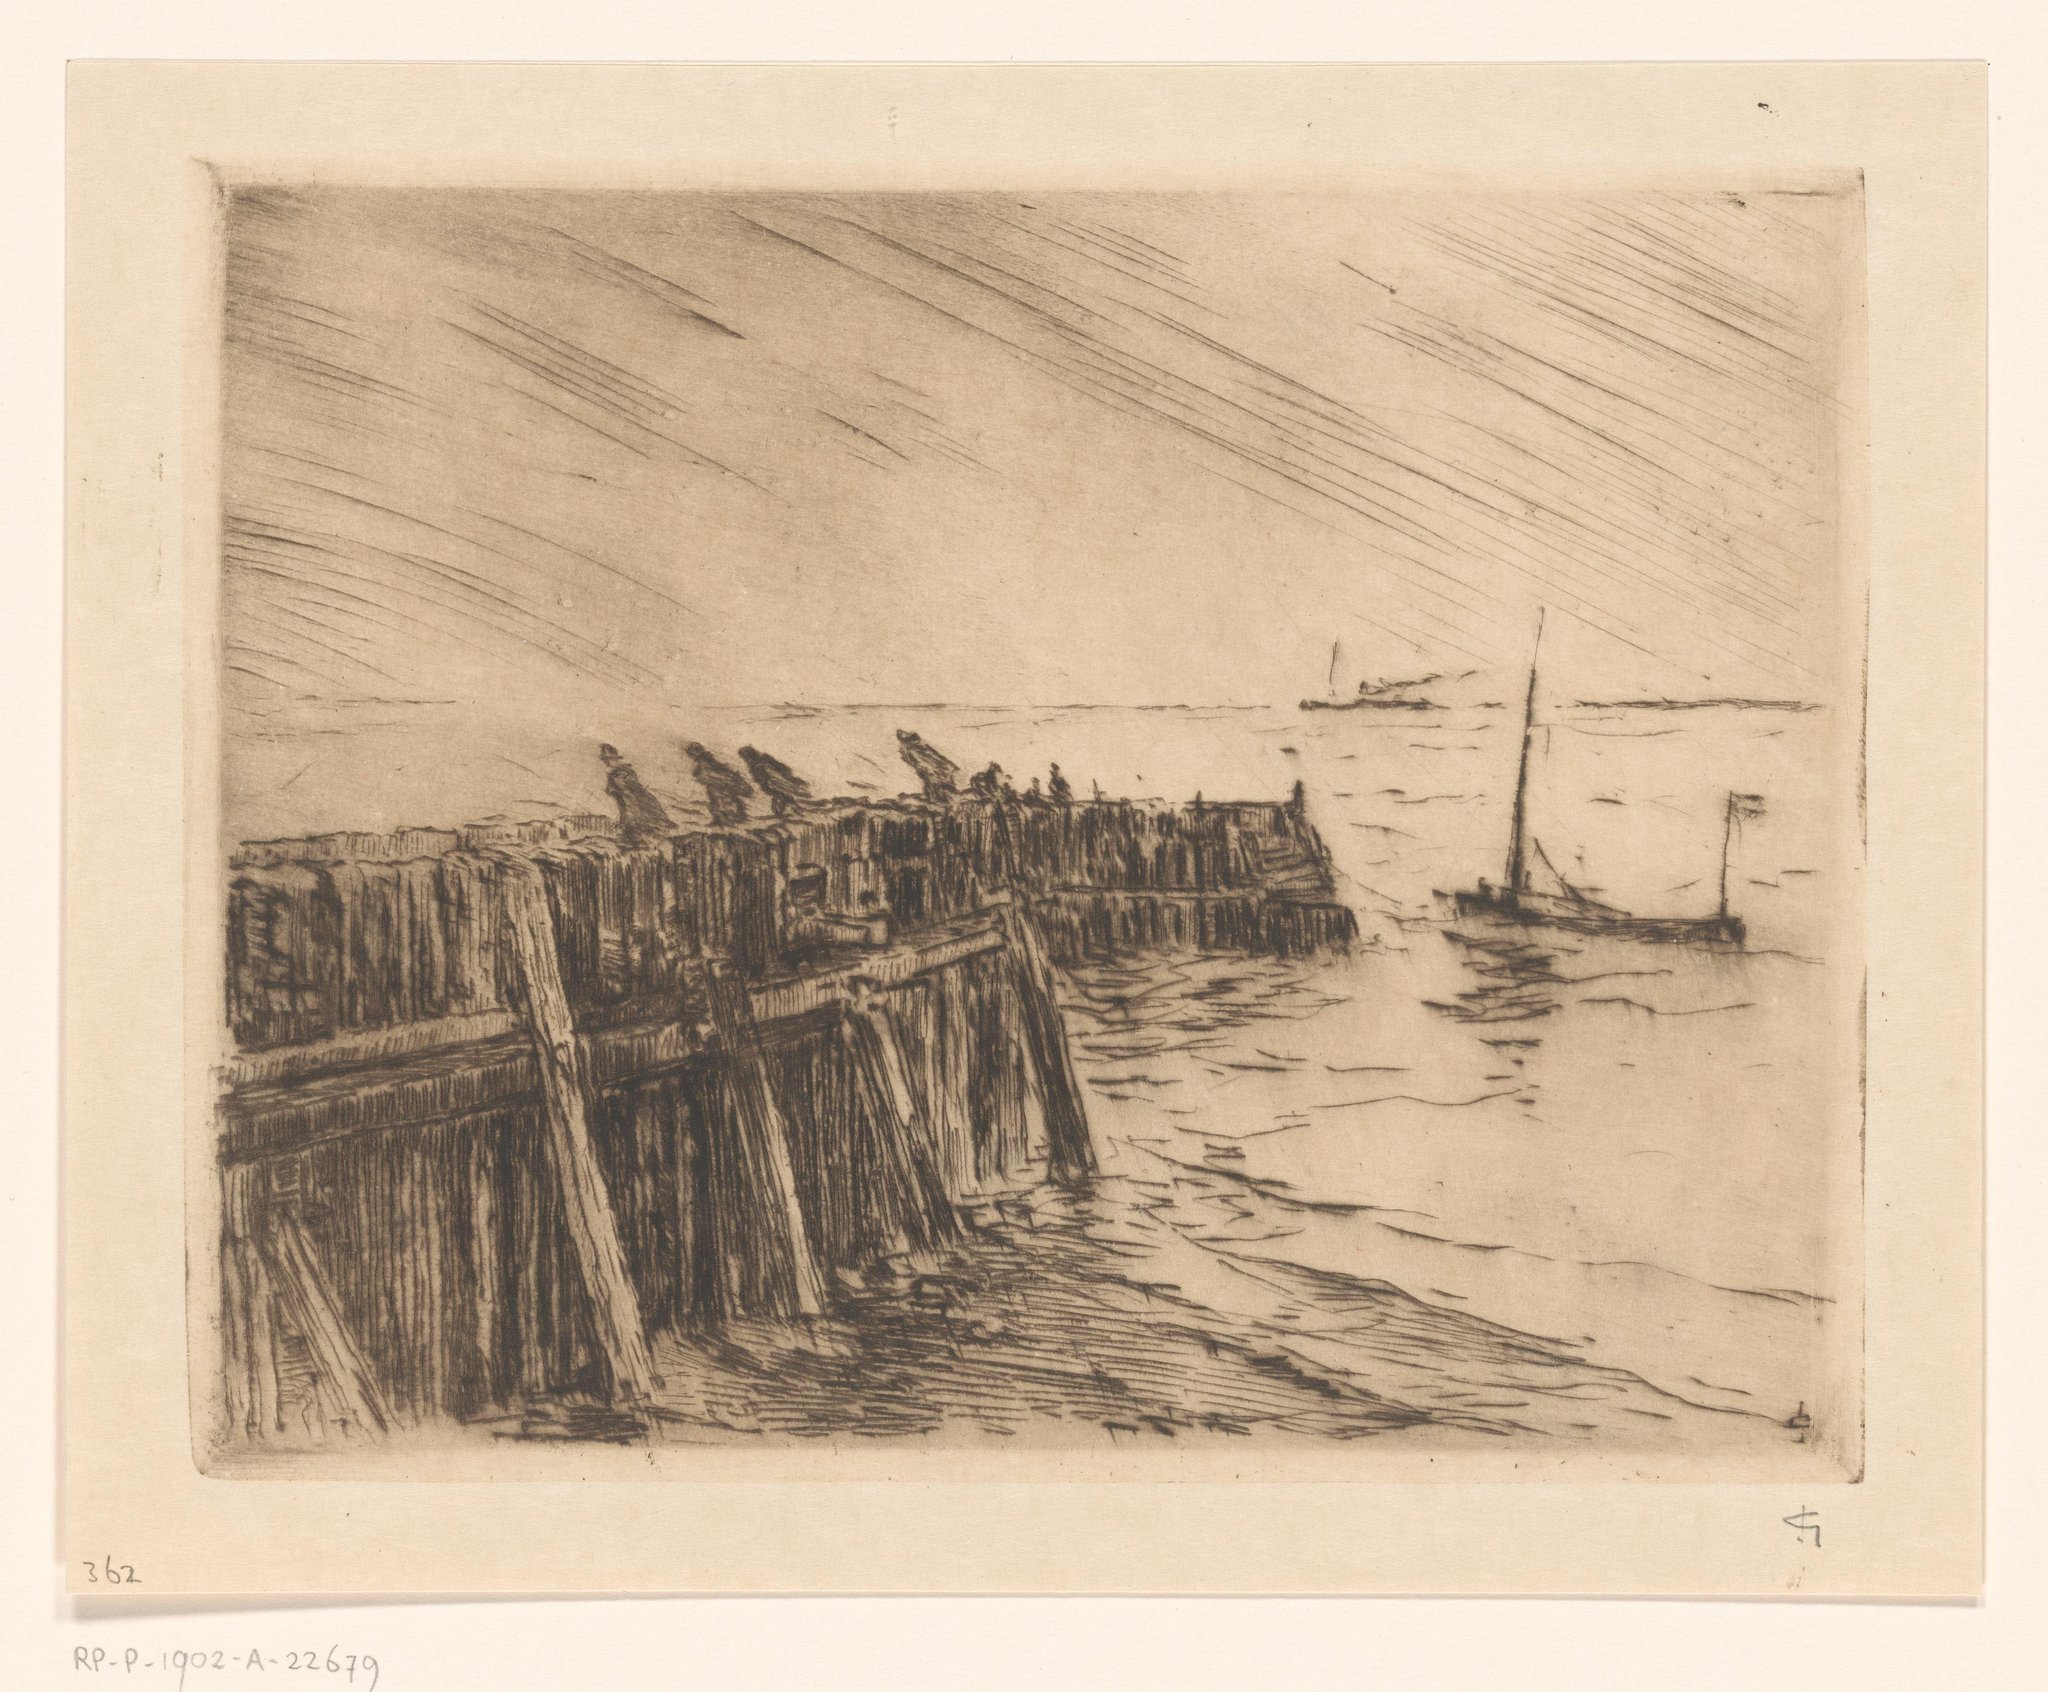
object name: print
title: Havenhoofd in Vlissingen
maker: carel nicolaas storm van s-gravesande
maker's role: draughtsman, print maker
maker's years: 1841-1924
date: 1889-1902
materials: paper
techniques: drypoint, intaglio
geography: netherlands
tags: coastal protection work, breakwater (+ landscape with figures, staffage), flushing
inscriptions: number: ‘362’, collector's mark: Lugt 2228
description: Mogelijk vermeld in: Storm van 's-Gravesande, Charles. Catalogue des eaux-fortes et lithographies. New York: s.n., 1903, of in een onbekende latere uitgave van het manuscript. Vermoedelijk vermeld als catalogusnummer 362.